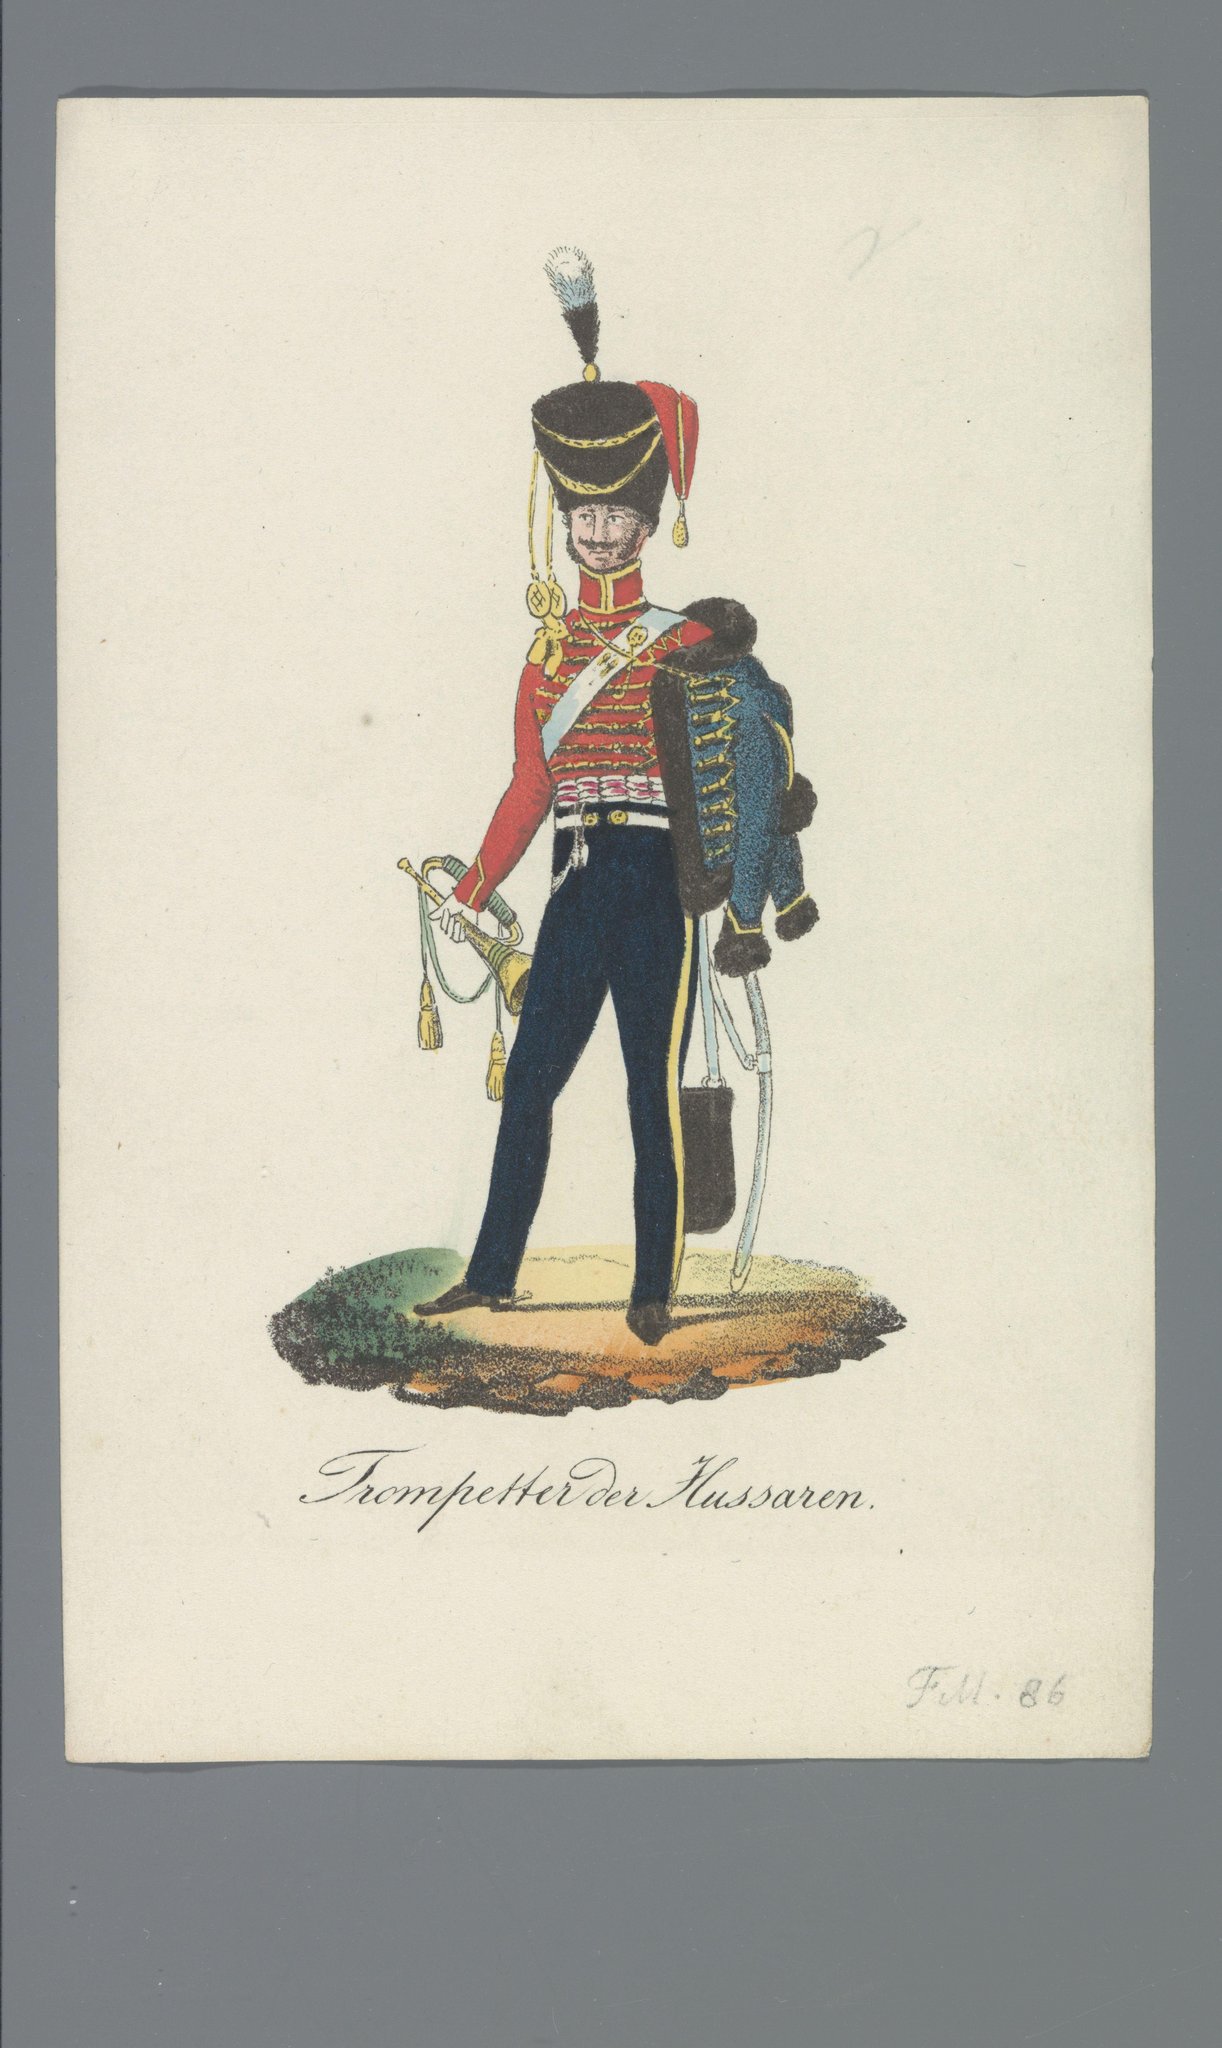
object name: print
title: Trompetter der Hussaren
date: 1835-1850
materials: paper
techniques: hand coloring, lithograph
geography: utrecht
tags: (military) uniforms, clothes, costume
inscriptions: collector's mark: Lugt 2228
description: Een trompetter van de huzaren, te voet. Onderdeel van een serie van 157 losse bladen met Nederlandse militaire uniformen in de jaren 1830-1832.